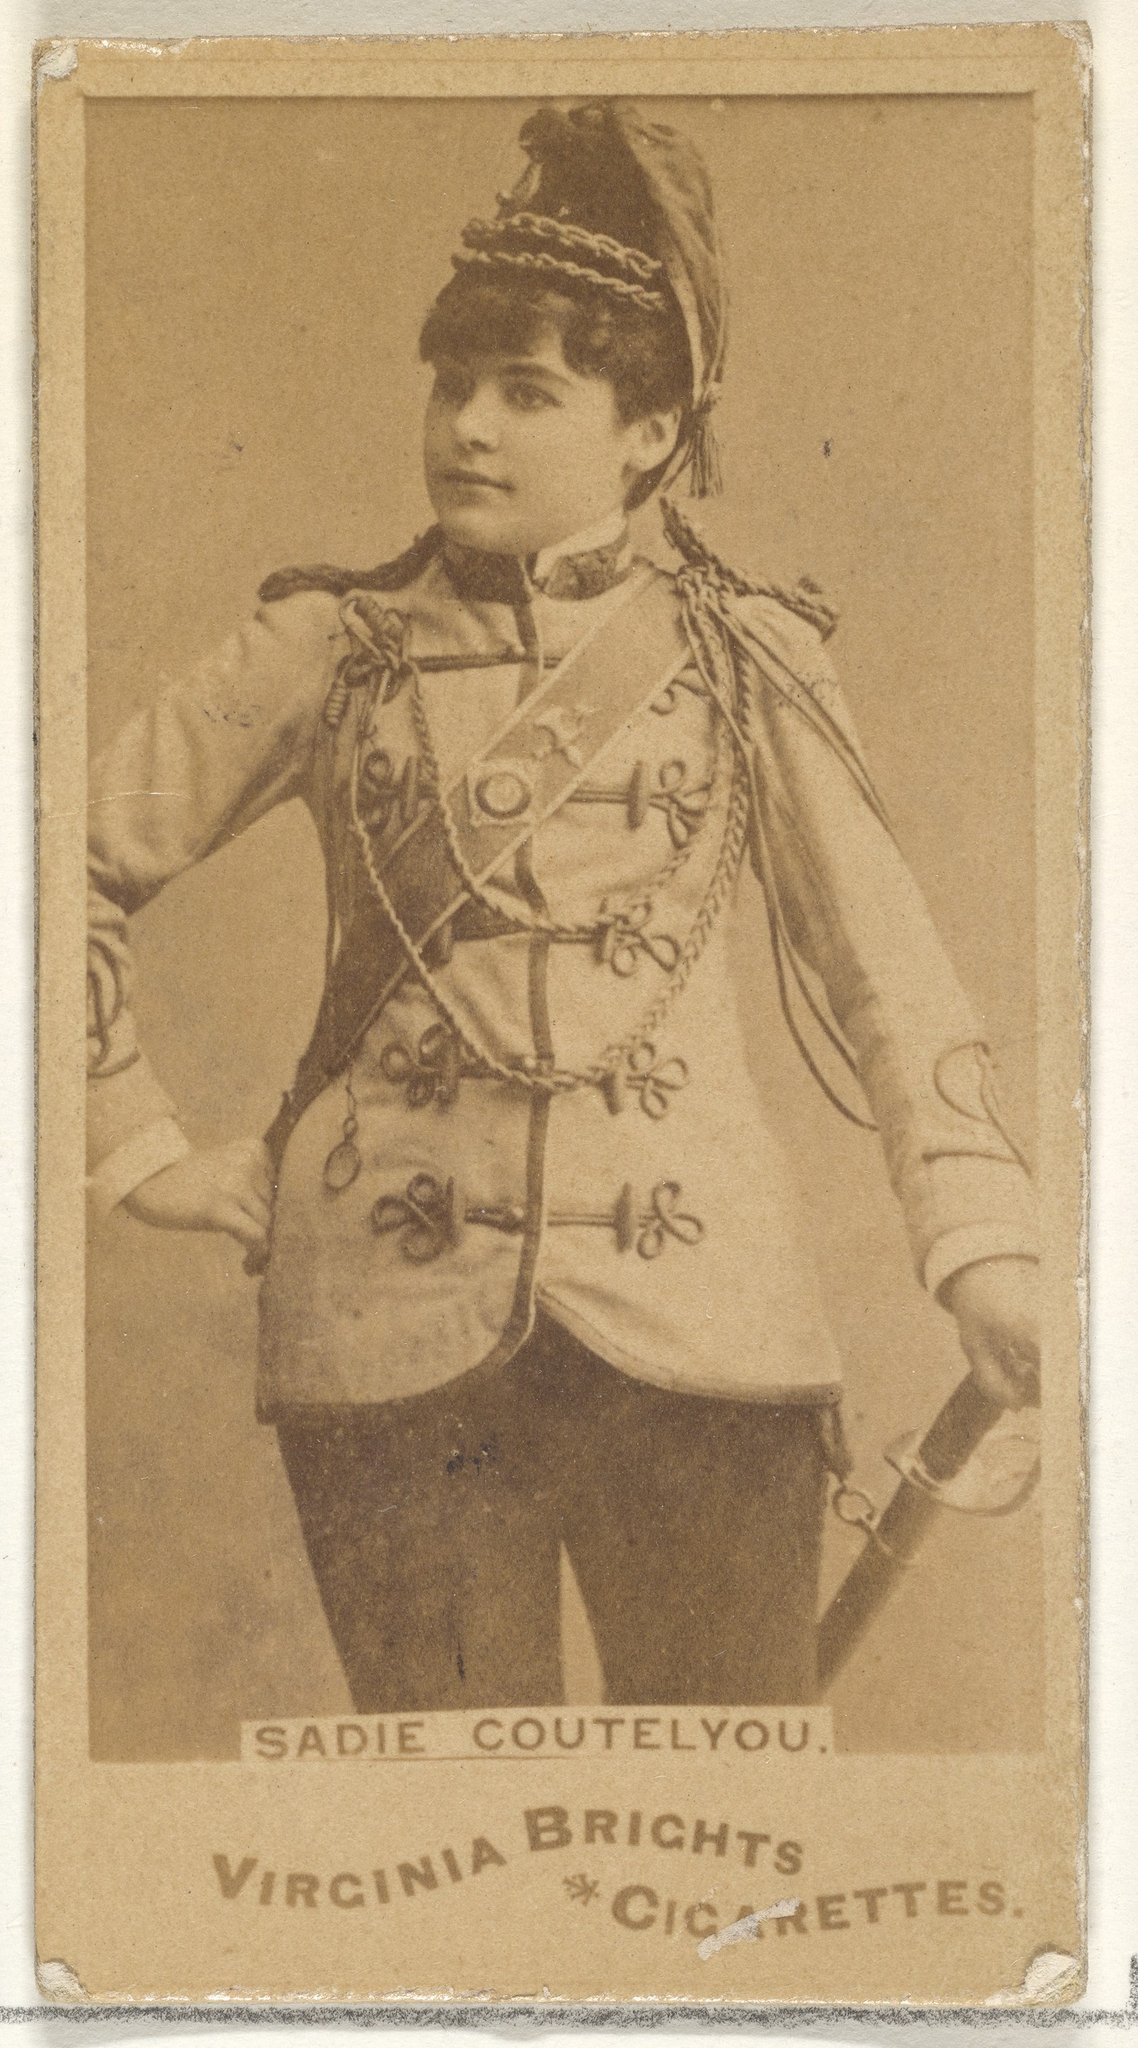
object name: photograph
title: Sadie Cortelyou, from the Actors and Actresses series (N45, Type 1) for Virginia Brights Cigarettes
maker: allen & ginter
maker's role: publisher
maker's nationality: american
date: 1888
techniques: albumen silver print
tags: portraits,women,actresses